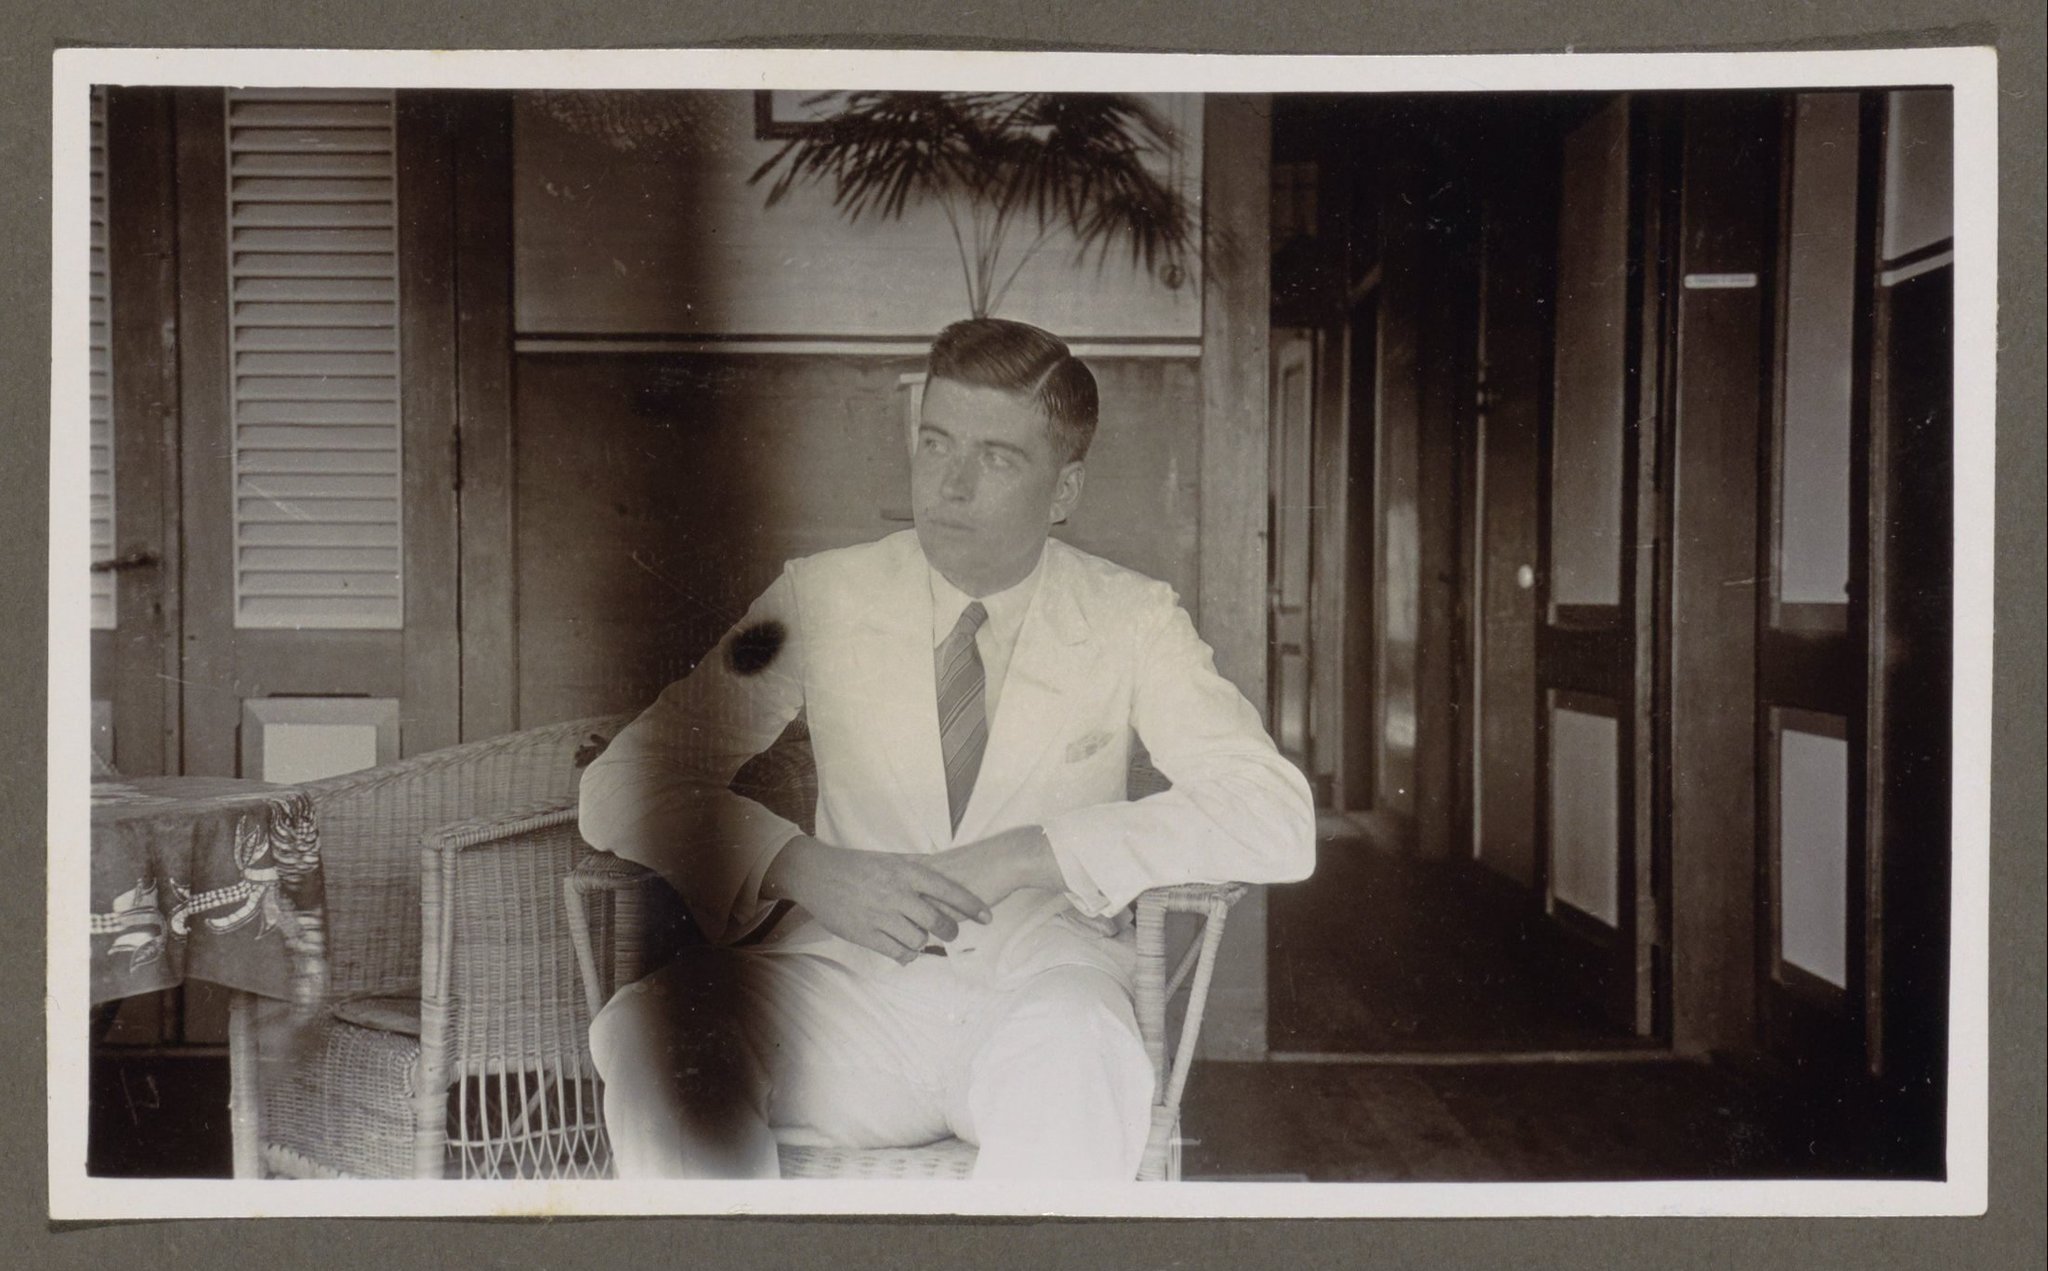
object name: photograph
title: Man in een wit kostuum zittend in een rieten fauteuil, de handen op elkaar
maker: Anonymous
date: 1920-1930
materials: photographic support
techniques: gelatin silver print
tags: armchair, seat, interior of the house, dutch east indies, the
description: Onderdeel van familiealbum Nederlands-Indië.